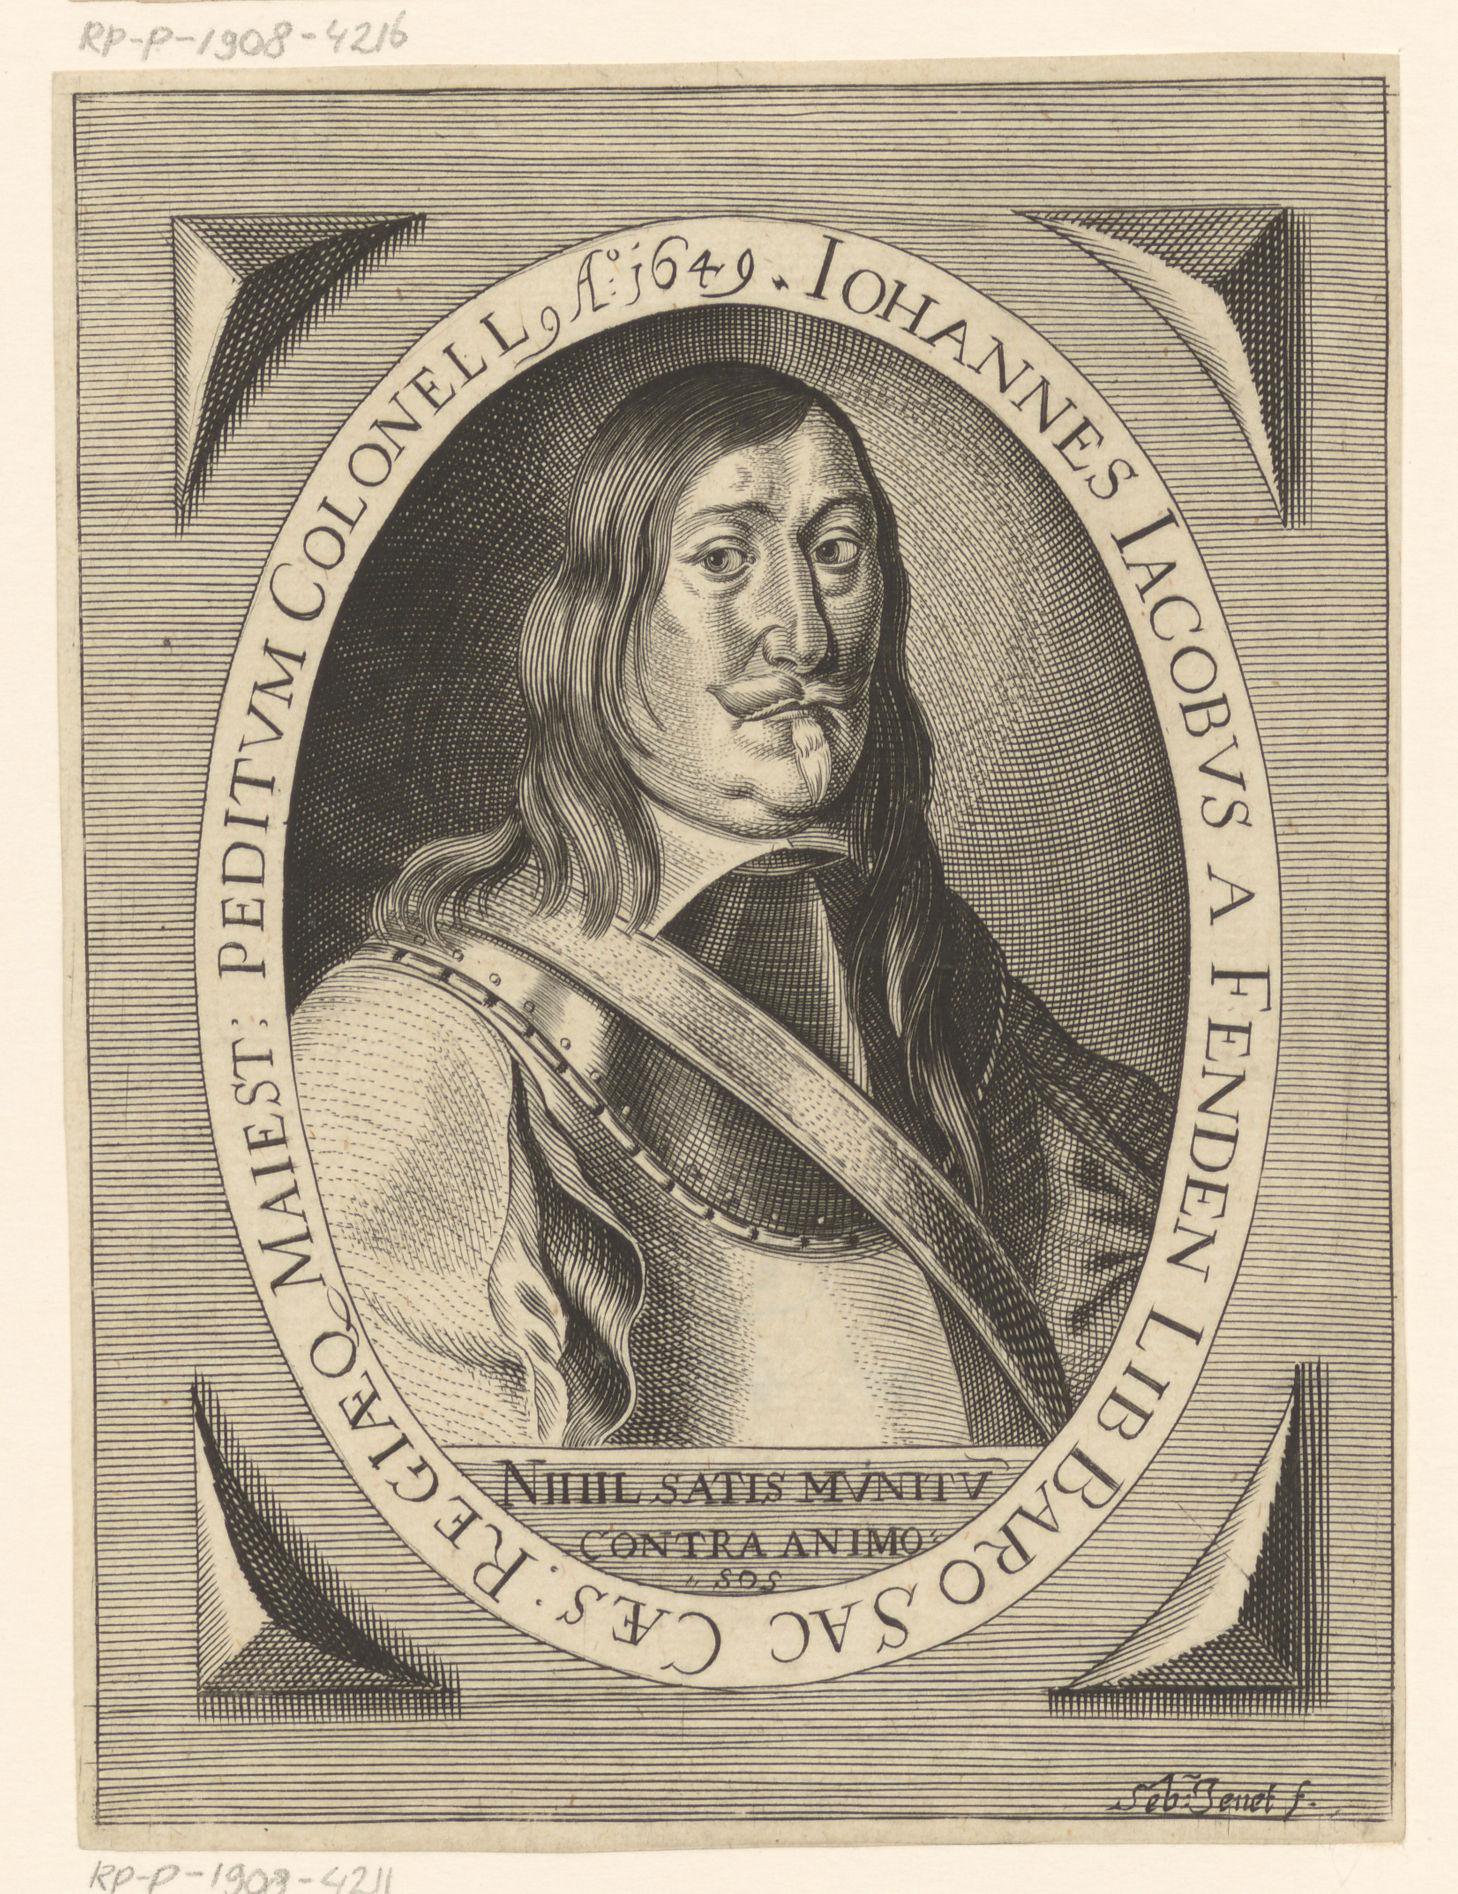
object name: print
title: Portret van Johann Jacob von Fenden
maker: sebastian jenet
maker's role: draughtsman, print maker, publisher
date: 1649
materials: paper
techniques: engraving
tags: historical persons, officer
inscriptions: collector's mark: Lugt 2228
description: Deze prent maakt deel uit van een serie van achttien portretten voor: Widemann, Elias. Comitium Gloriae Centum Qua Sanguine Qua Virtute Illustrium Heroum Iconibus Instructum Et Excelmo. Ac Illustrissimo Heroi D.D. Joanni Christophoro Com: a Puchaim (...) Dicatum. Wenen: Matthaeus Cosmerovius, 1650.